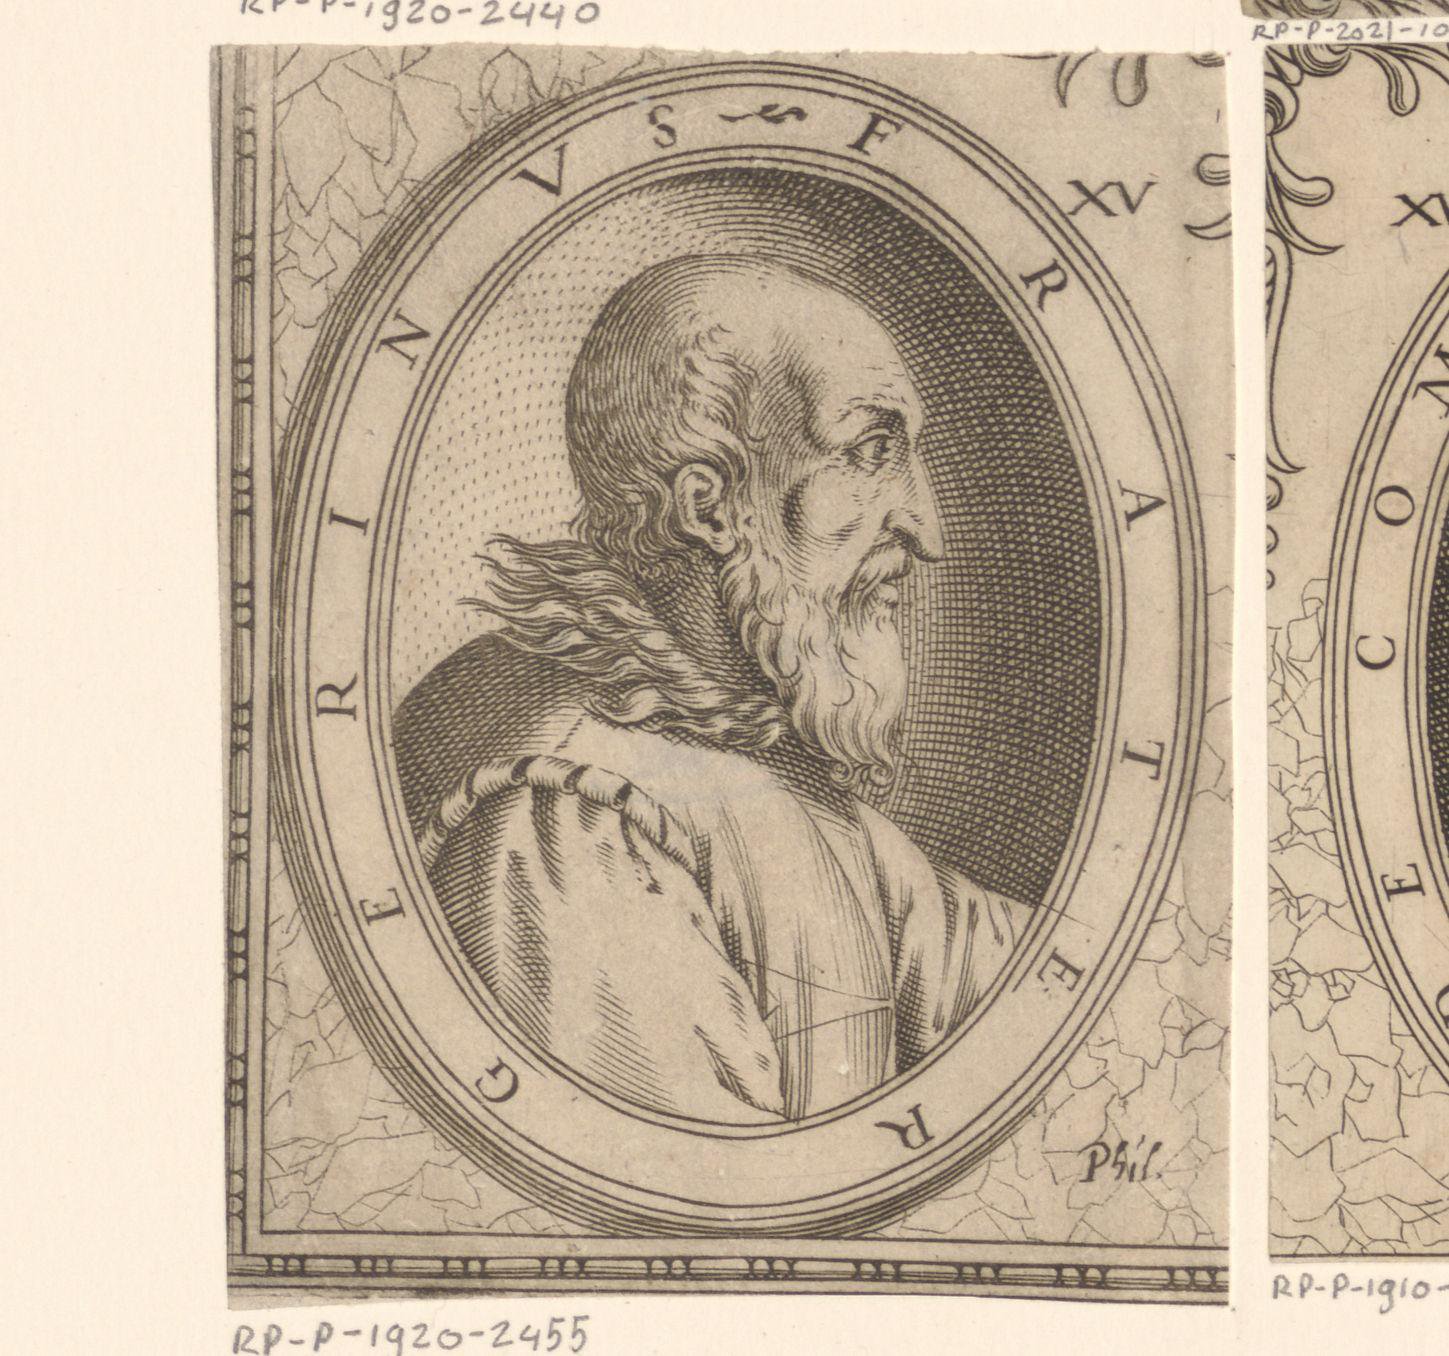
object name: print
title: Portret van Guérin Lebrun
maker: philippe thomassin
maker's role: print maker, publisher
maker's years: 1562-1622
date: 1588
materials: paper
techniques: engraving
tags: historical persons, military orders, e.g.: knights templars, knights of malta, teutonic knights ~ roman catholic church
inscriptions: collector's mark: Lugt 2228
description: Deze prent maakt deel uit van een grotere prent met vier portretten die later is verknipt. Prent waarschijnlijk uit: Veltroni, Tolomeo. Statuta hospitalis Hierusalem. [Rome: s.n., 1588].